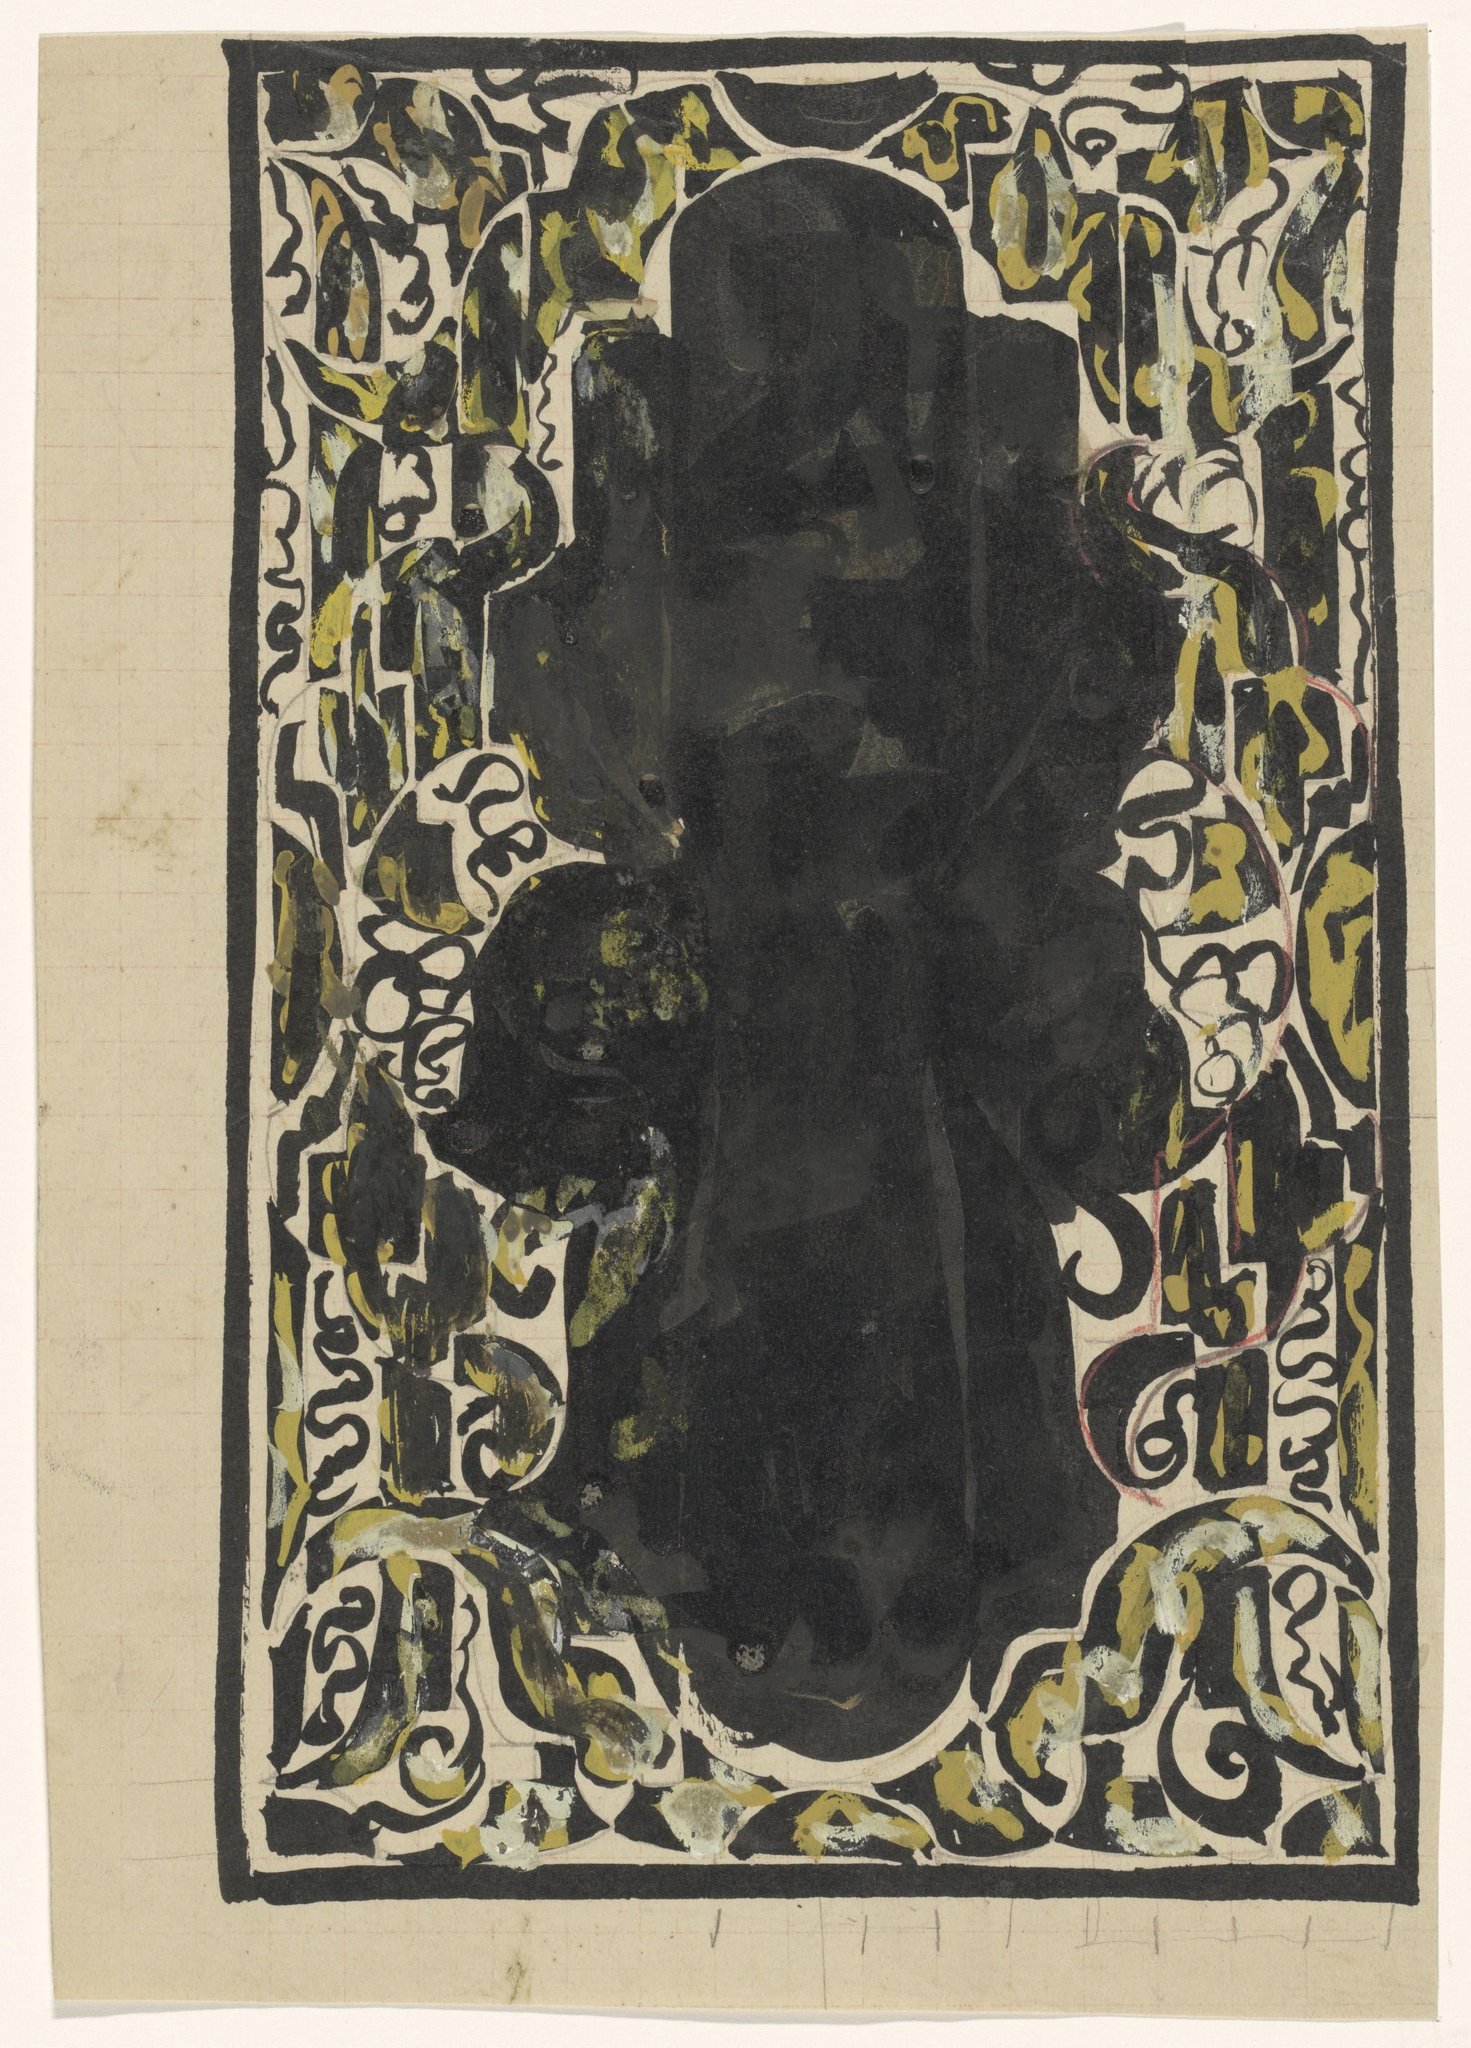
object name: design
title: Decoratief ontwerp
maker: carel adolph lion cachet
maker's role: draughtsman, print maker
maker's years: 1864-1945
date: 1874-1945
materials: chalk, pencil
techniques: brush